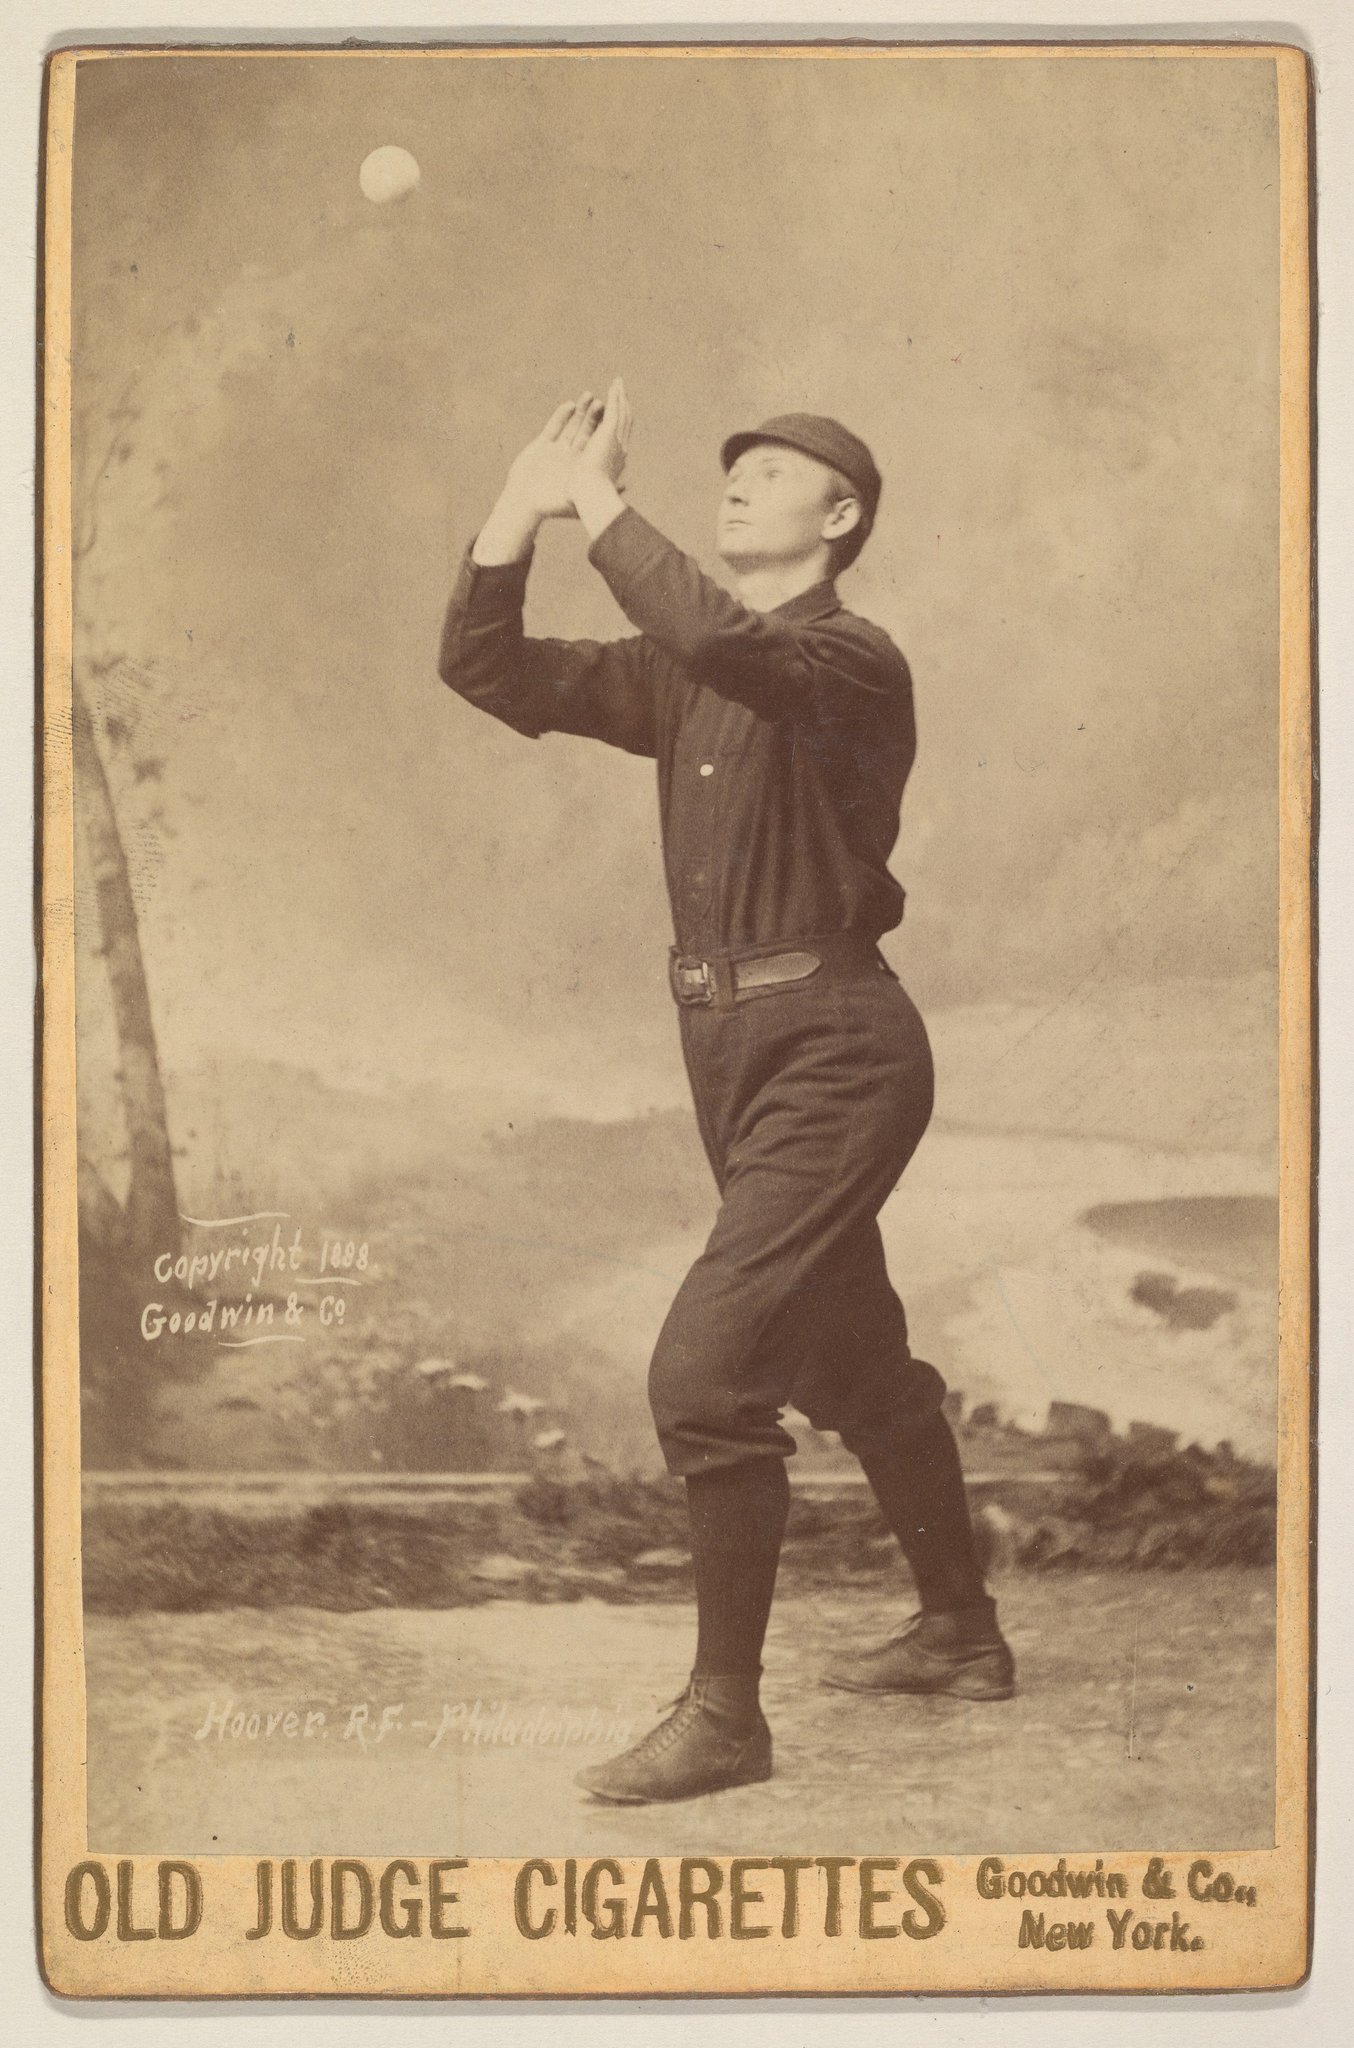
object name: baseball card, photograph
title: Hoover, Right Field, Philadelphia, from the series Old Judge Cigarettes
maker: goodwin & company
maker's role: publisher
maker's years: 1850-1950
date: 1888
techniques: albumen silver print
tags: men,portraits,baseball,athletes